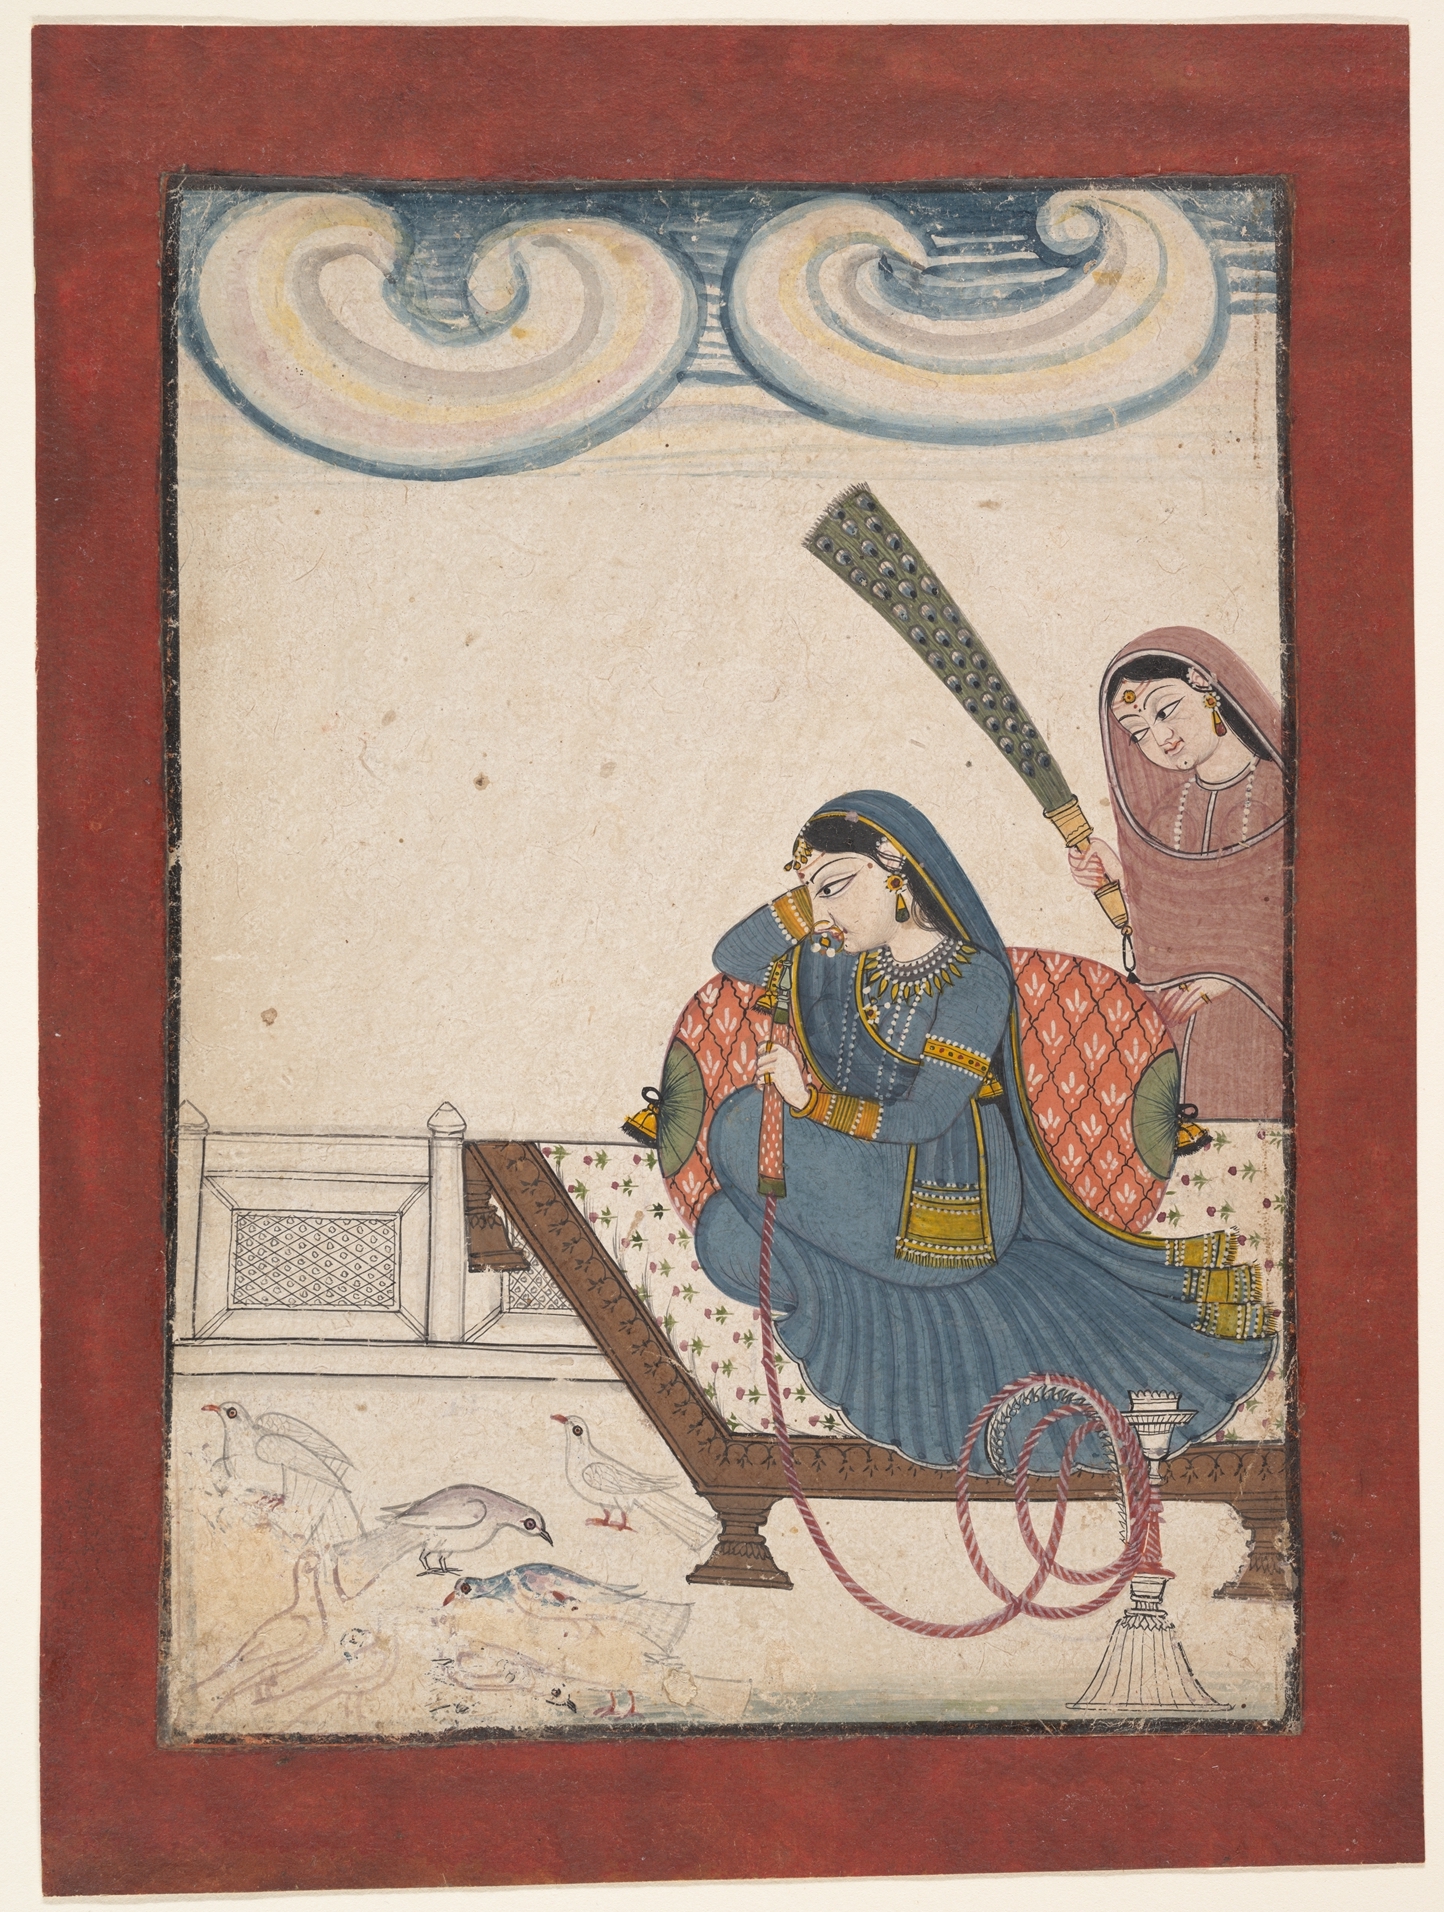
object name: painting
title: A Lady Gazing at Doves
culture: indian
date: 1780-1800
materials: ink, paper, watercolor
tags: doves,women,smoking